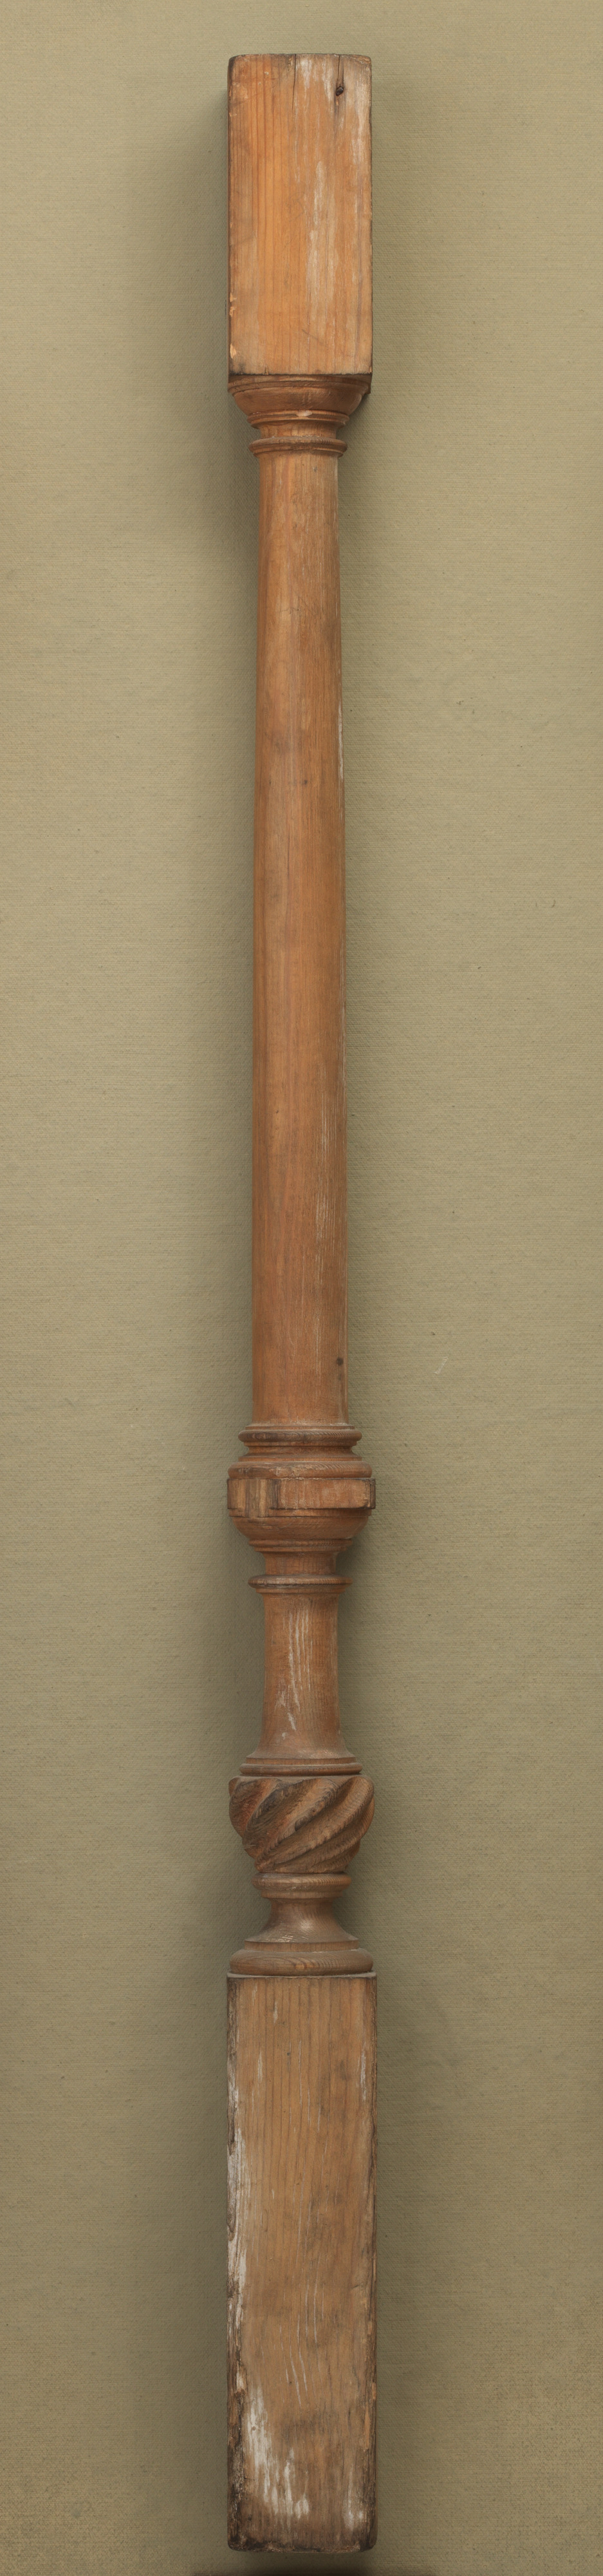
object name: baluster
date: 1734-1766